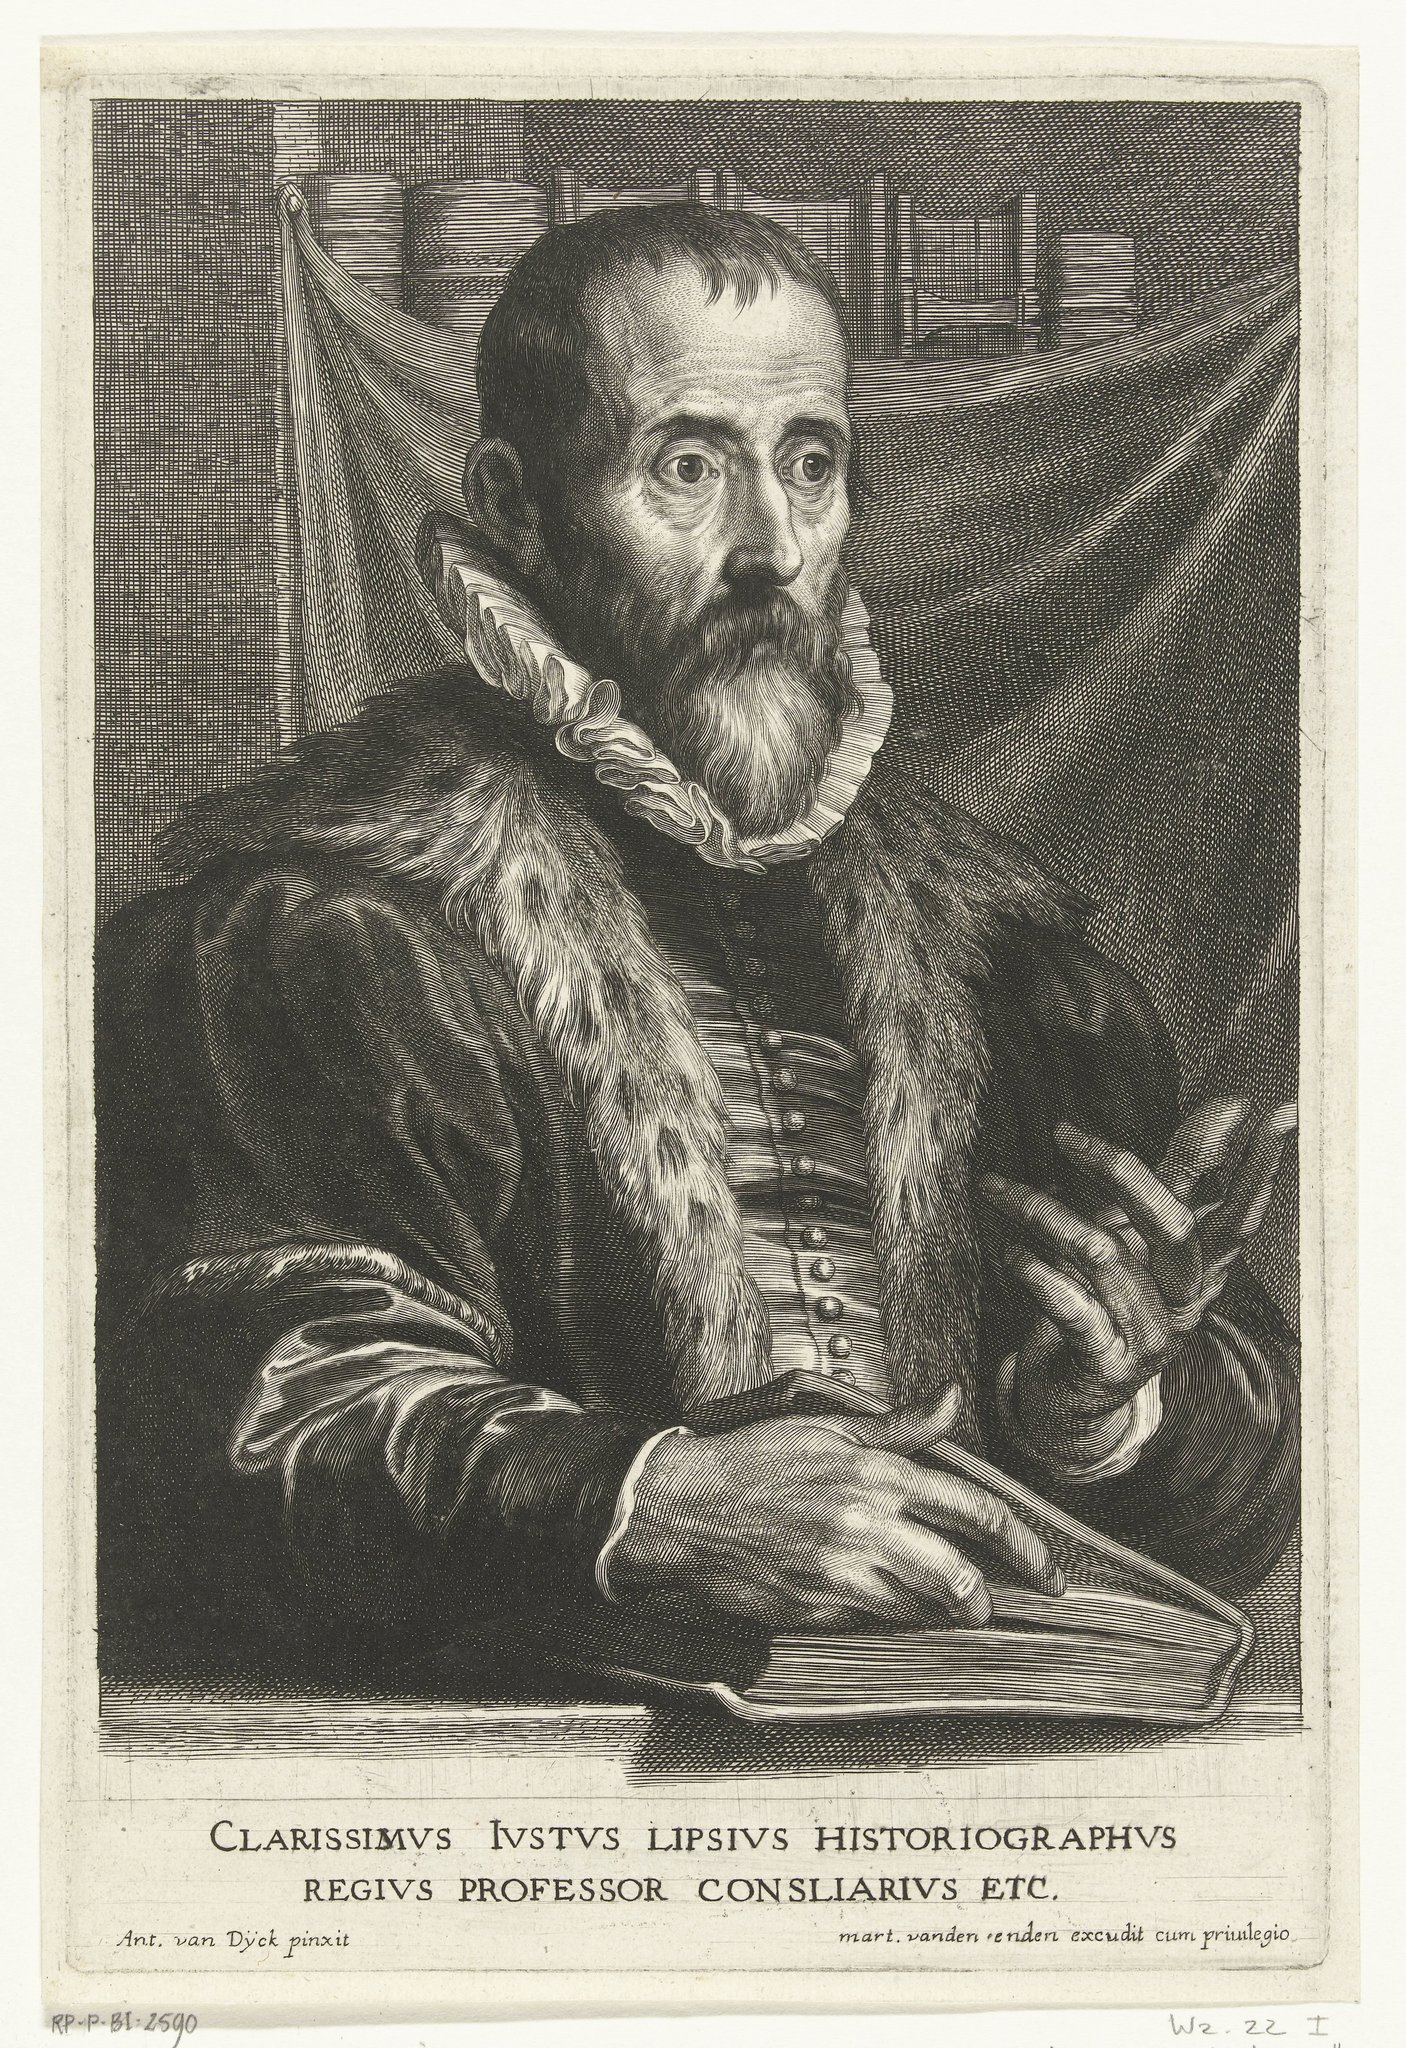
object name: print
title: Clarissimvs Ivstvs Lipsivs Historiographvs regivs professor consliarivs etc.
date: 1596-1659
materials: paper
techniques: engraving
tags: louvain, justus lipsius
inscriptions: collector's mark: Lugt 240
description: Prent naar schilderij van Anthony van Dyck.